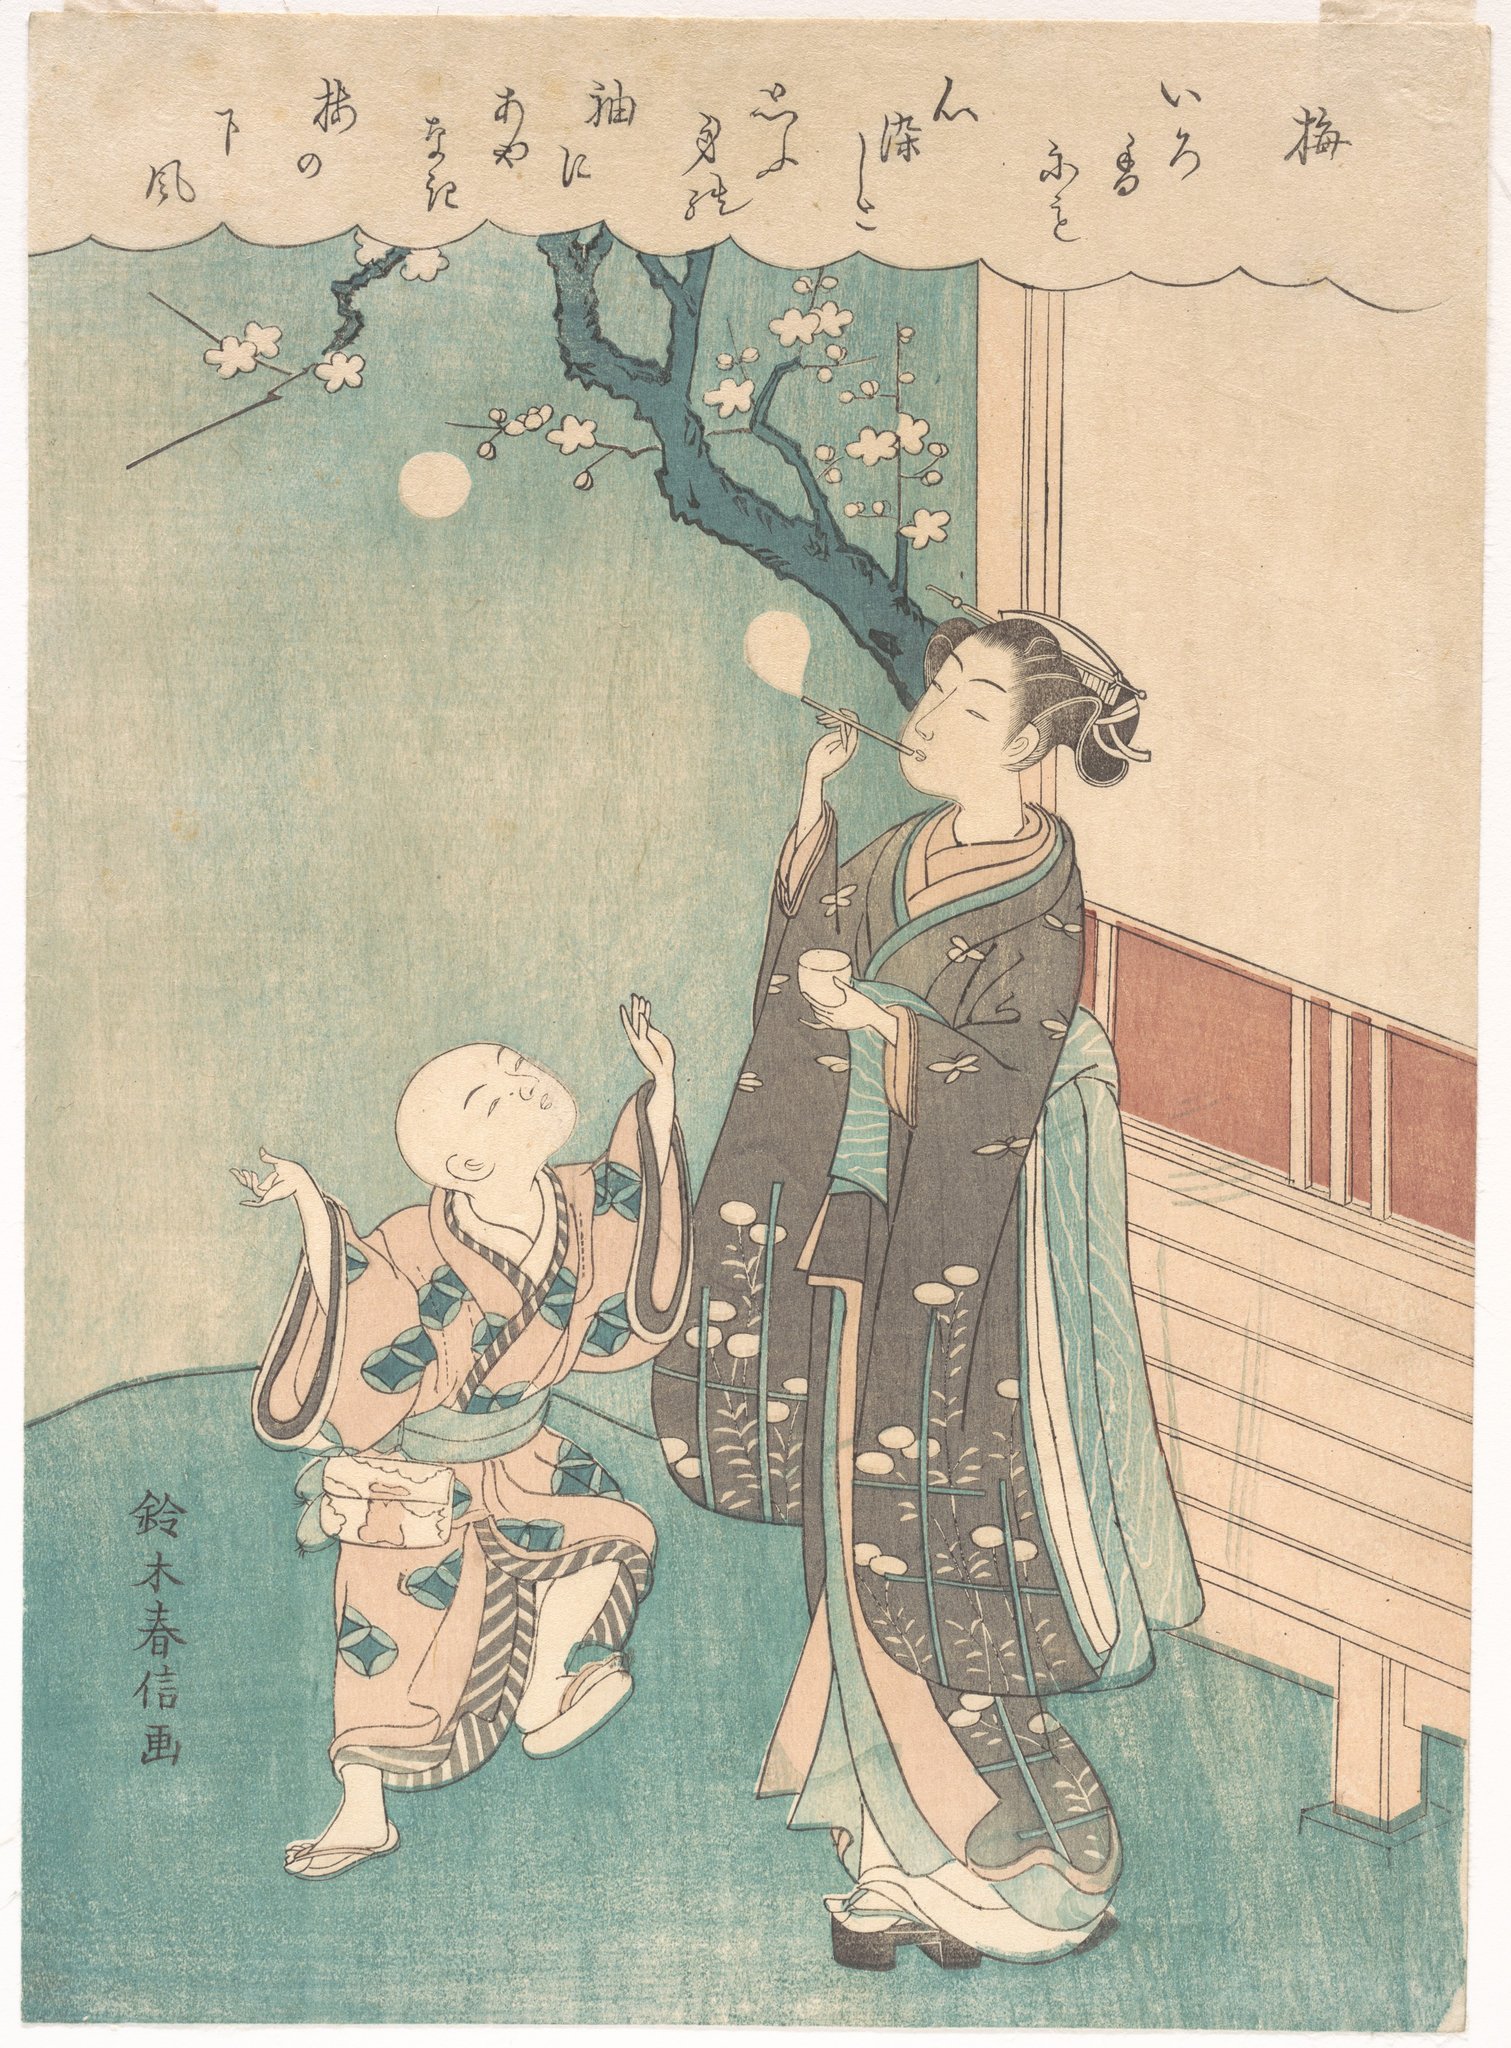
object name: print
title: Blowing Soap Bubbles Under the Plum Blossom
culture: japanese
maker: suzuki harunobu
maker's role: artist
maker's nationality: japanese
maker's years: 1725-1770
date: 1725-1770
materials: ink, paper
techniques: woodblock print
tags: boys,mothers,women,bubbles